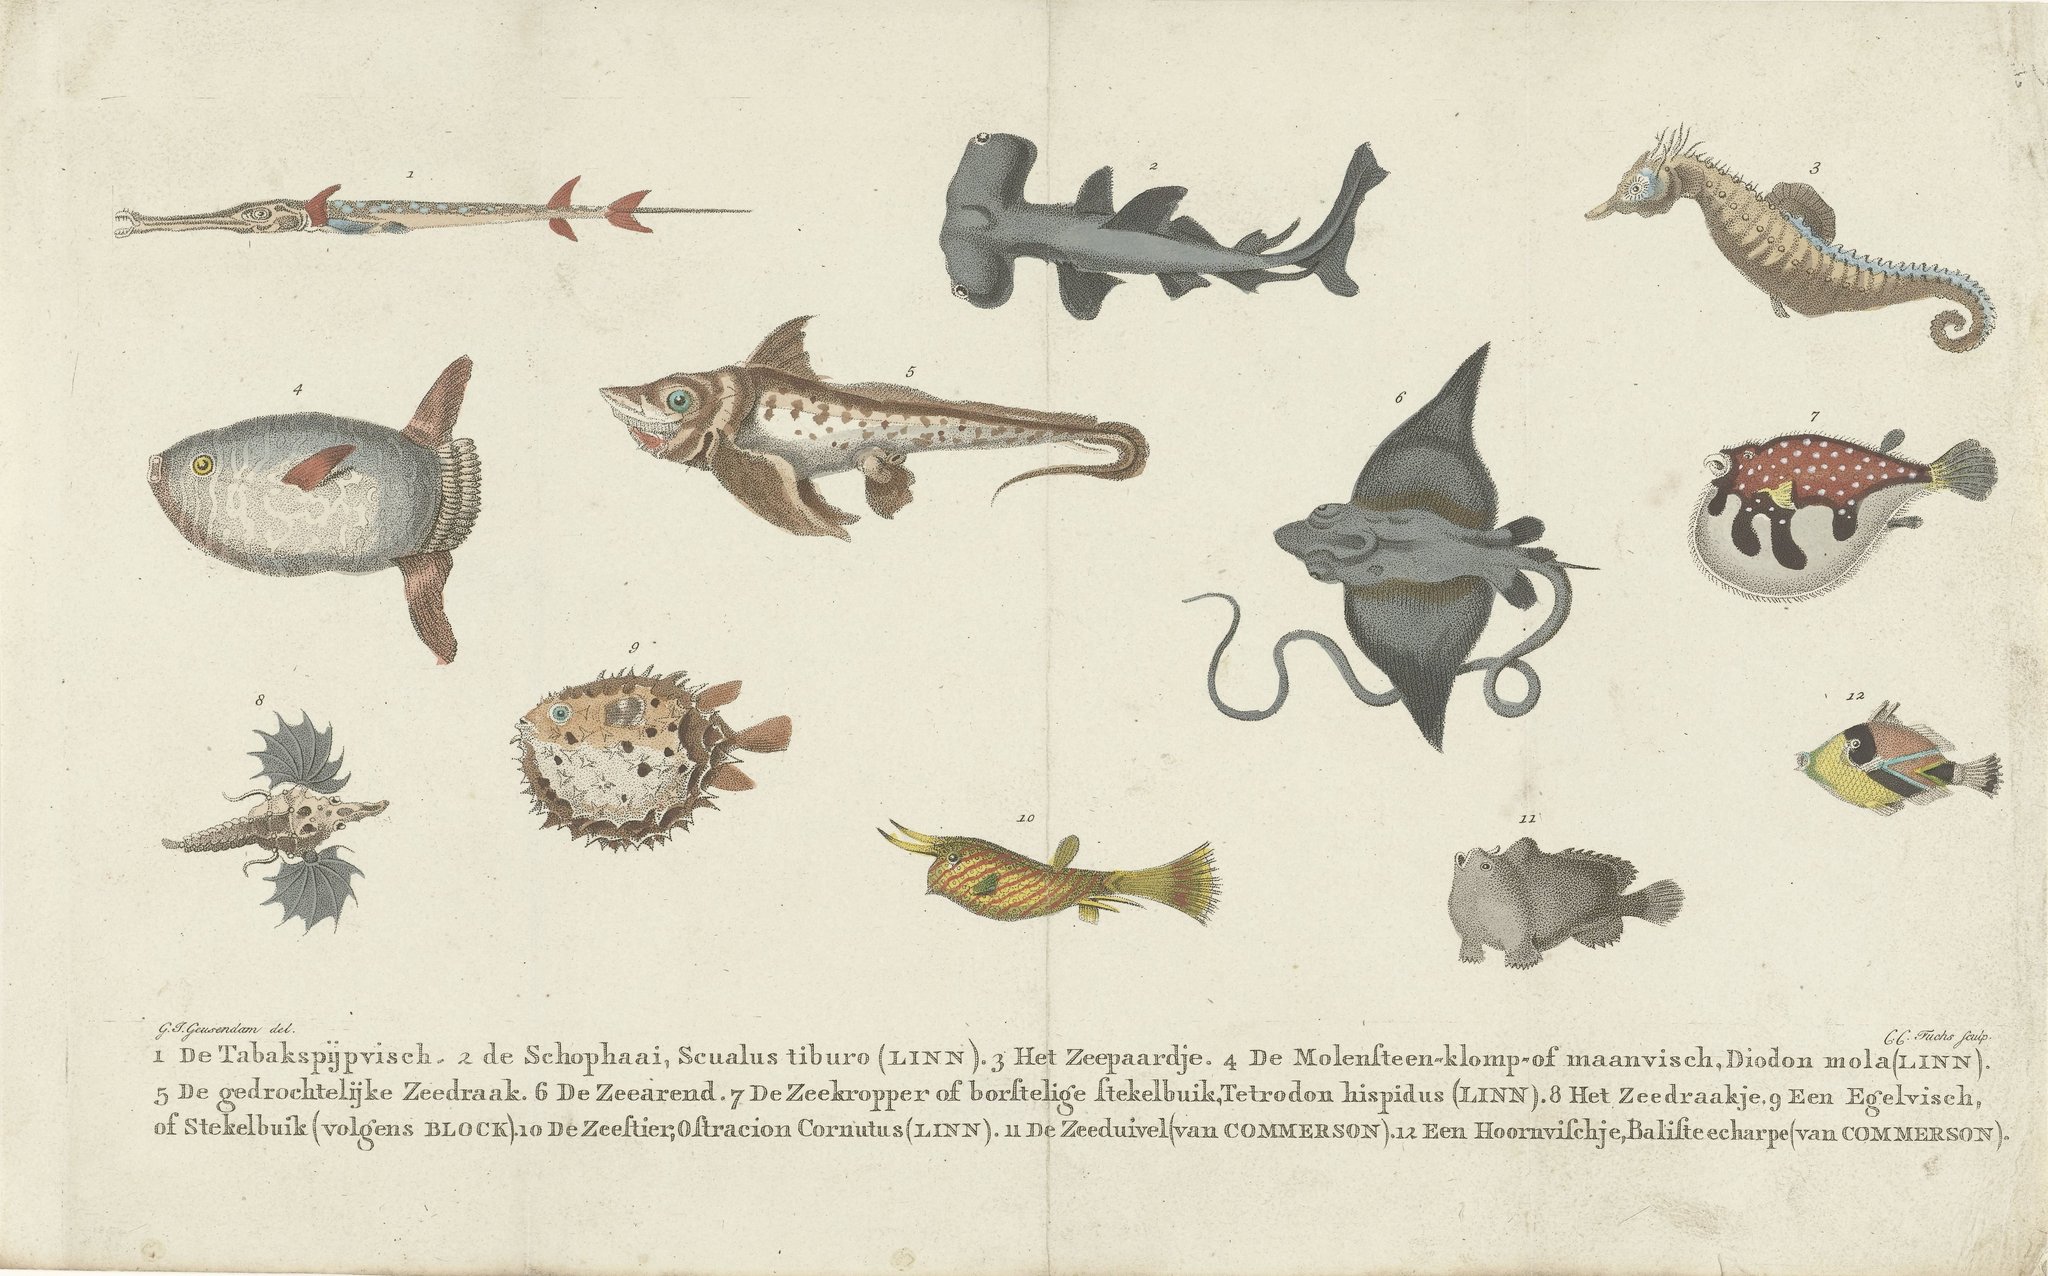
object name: print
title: Twelve different Fish Species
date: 1802-1855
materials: paper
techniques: etching, hand coloring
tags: fishes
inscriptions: collector's mark: Lugt 2228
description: Wetenschappelijke weergave van twaalf vissen met een legenda van 1 tot en met 12.